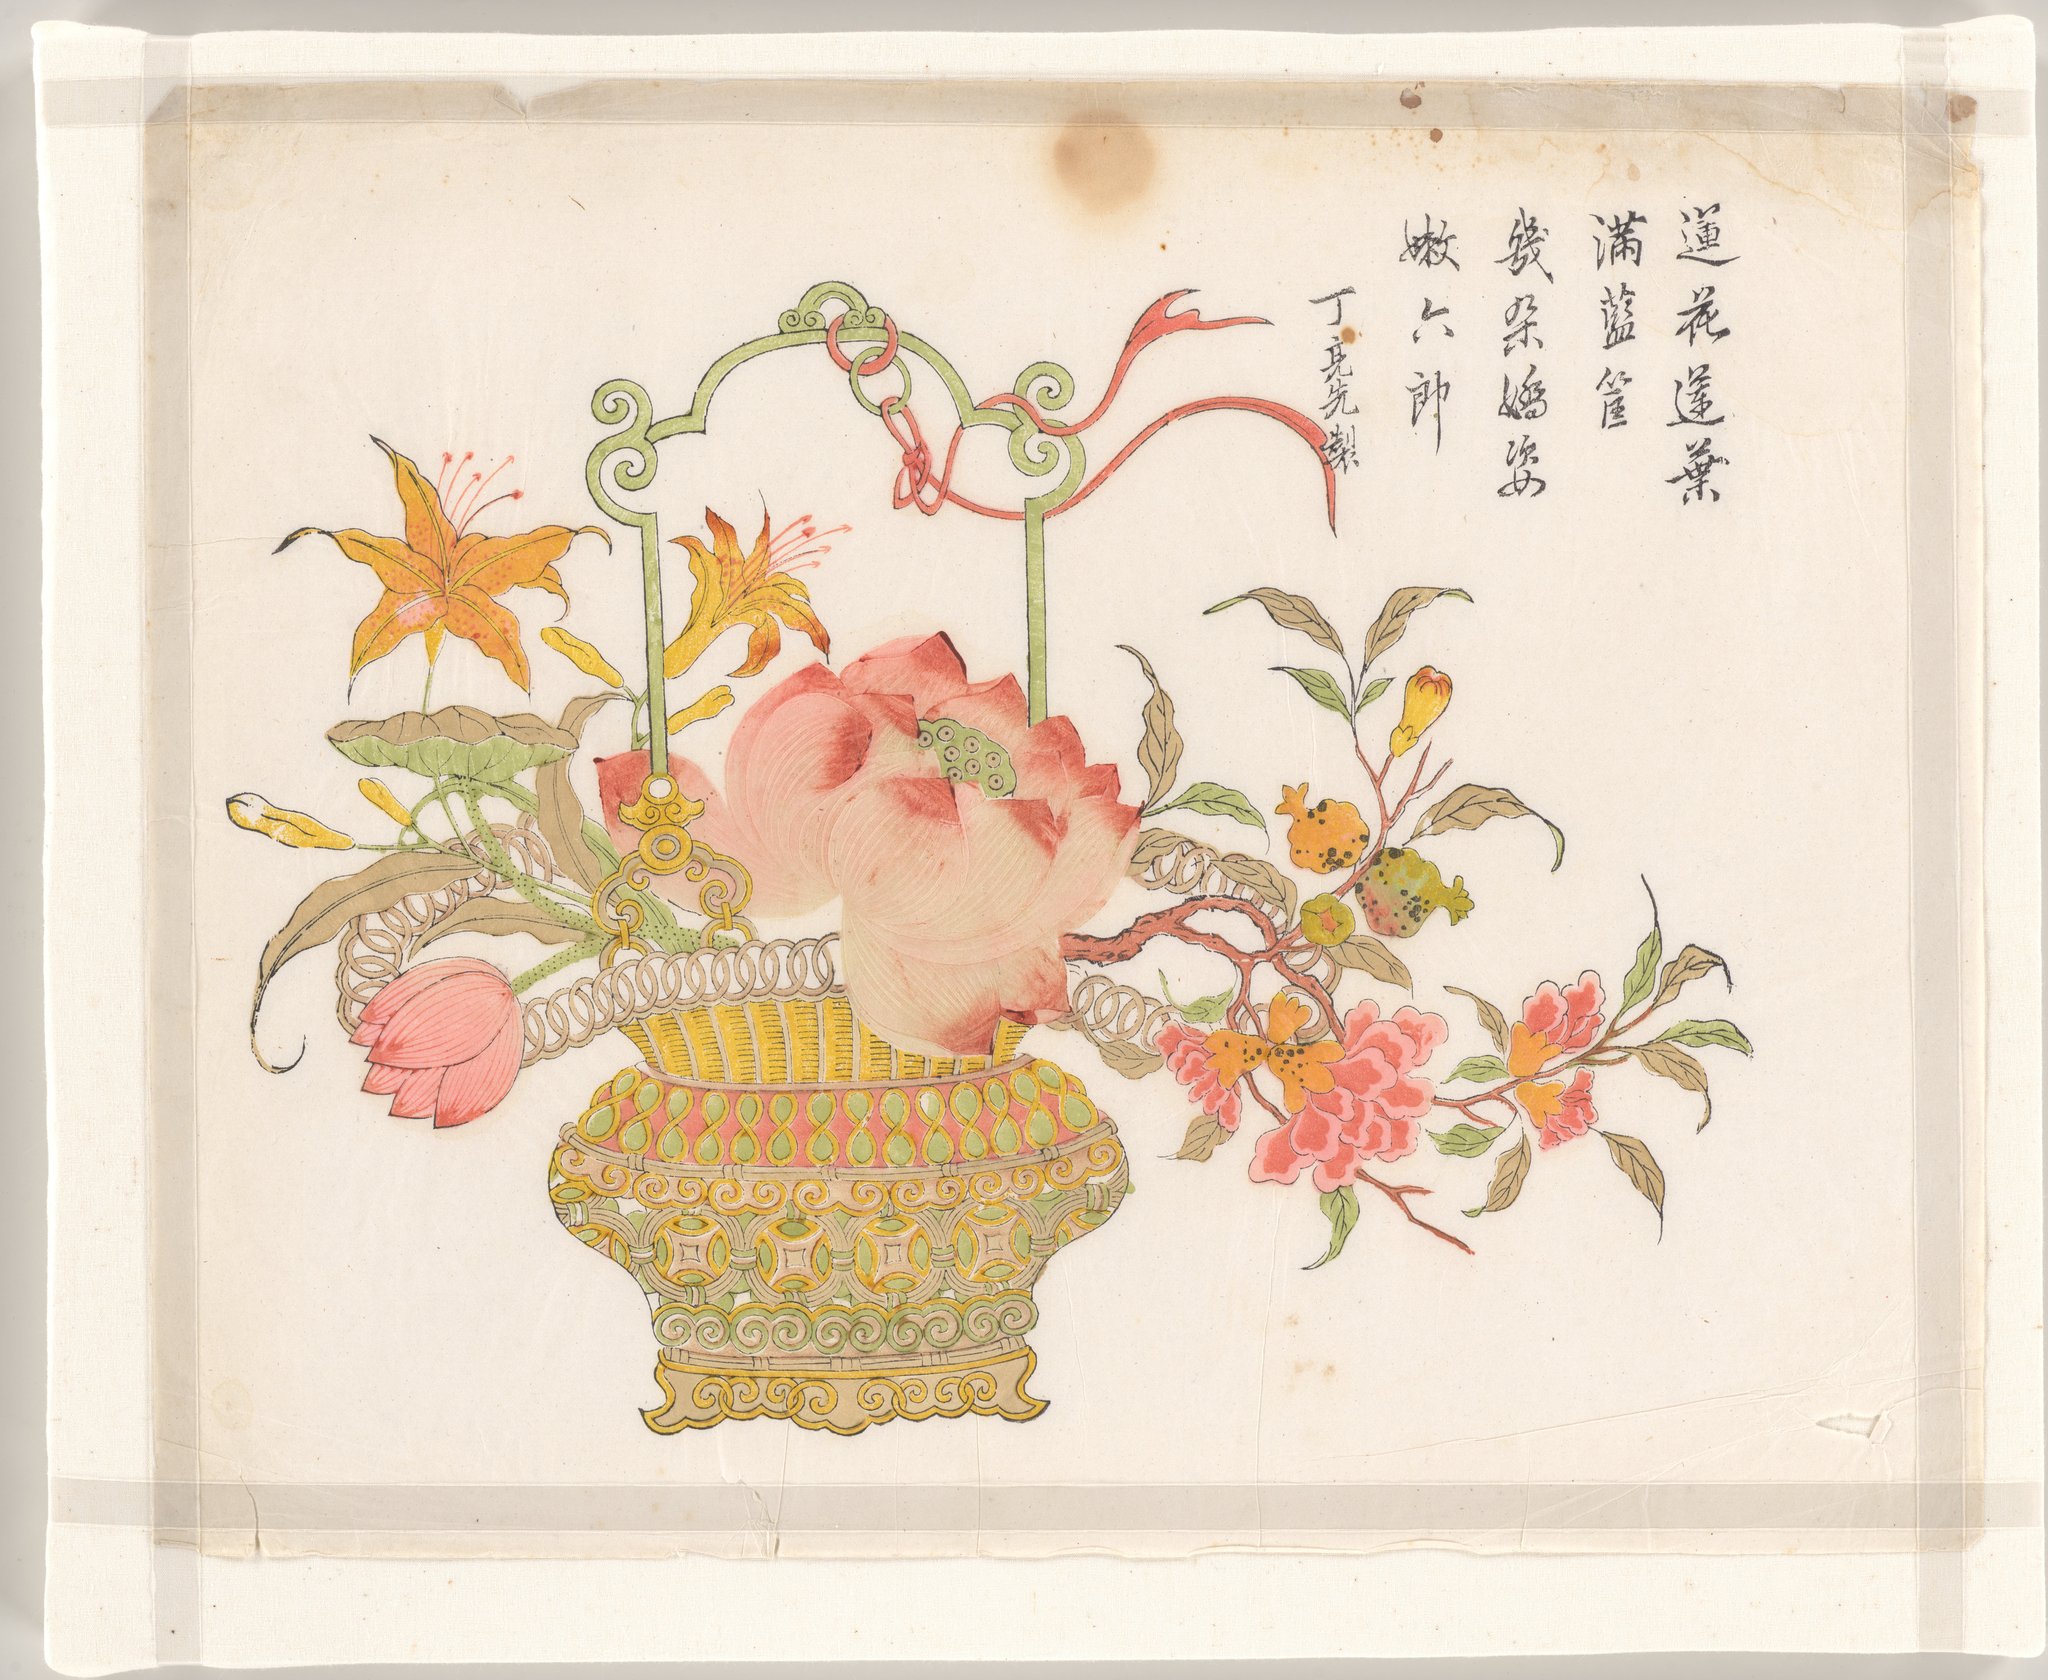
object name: print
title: Summer basket: lotus, pomegranate and day lily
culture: chinese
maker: ding liangxian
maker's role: artist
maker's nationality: chinese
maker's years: 1700-1749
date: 1701-1800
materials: ink, paper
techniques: polychrome, woodblock print